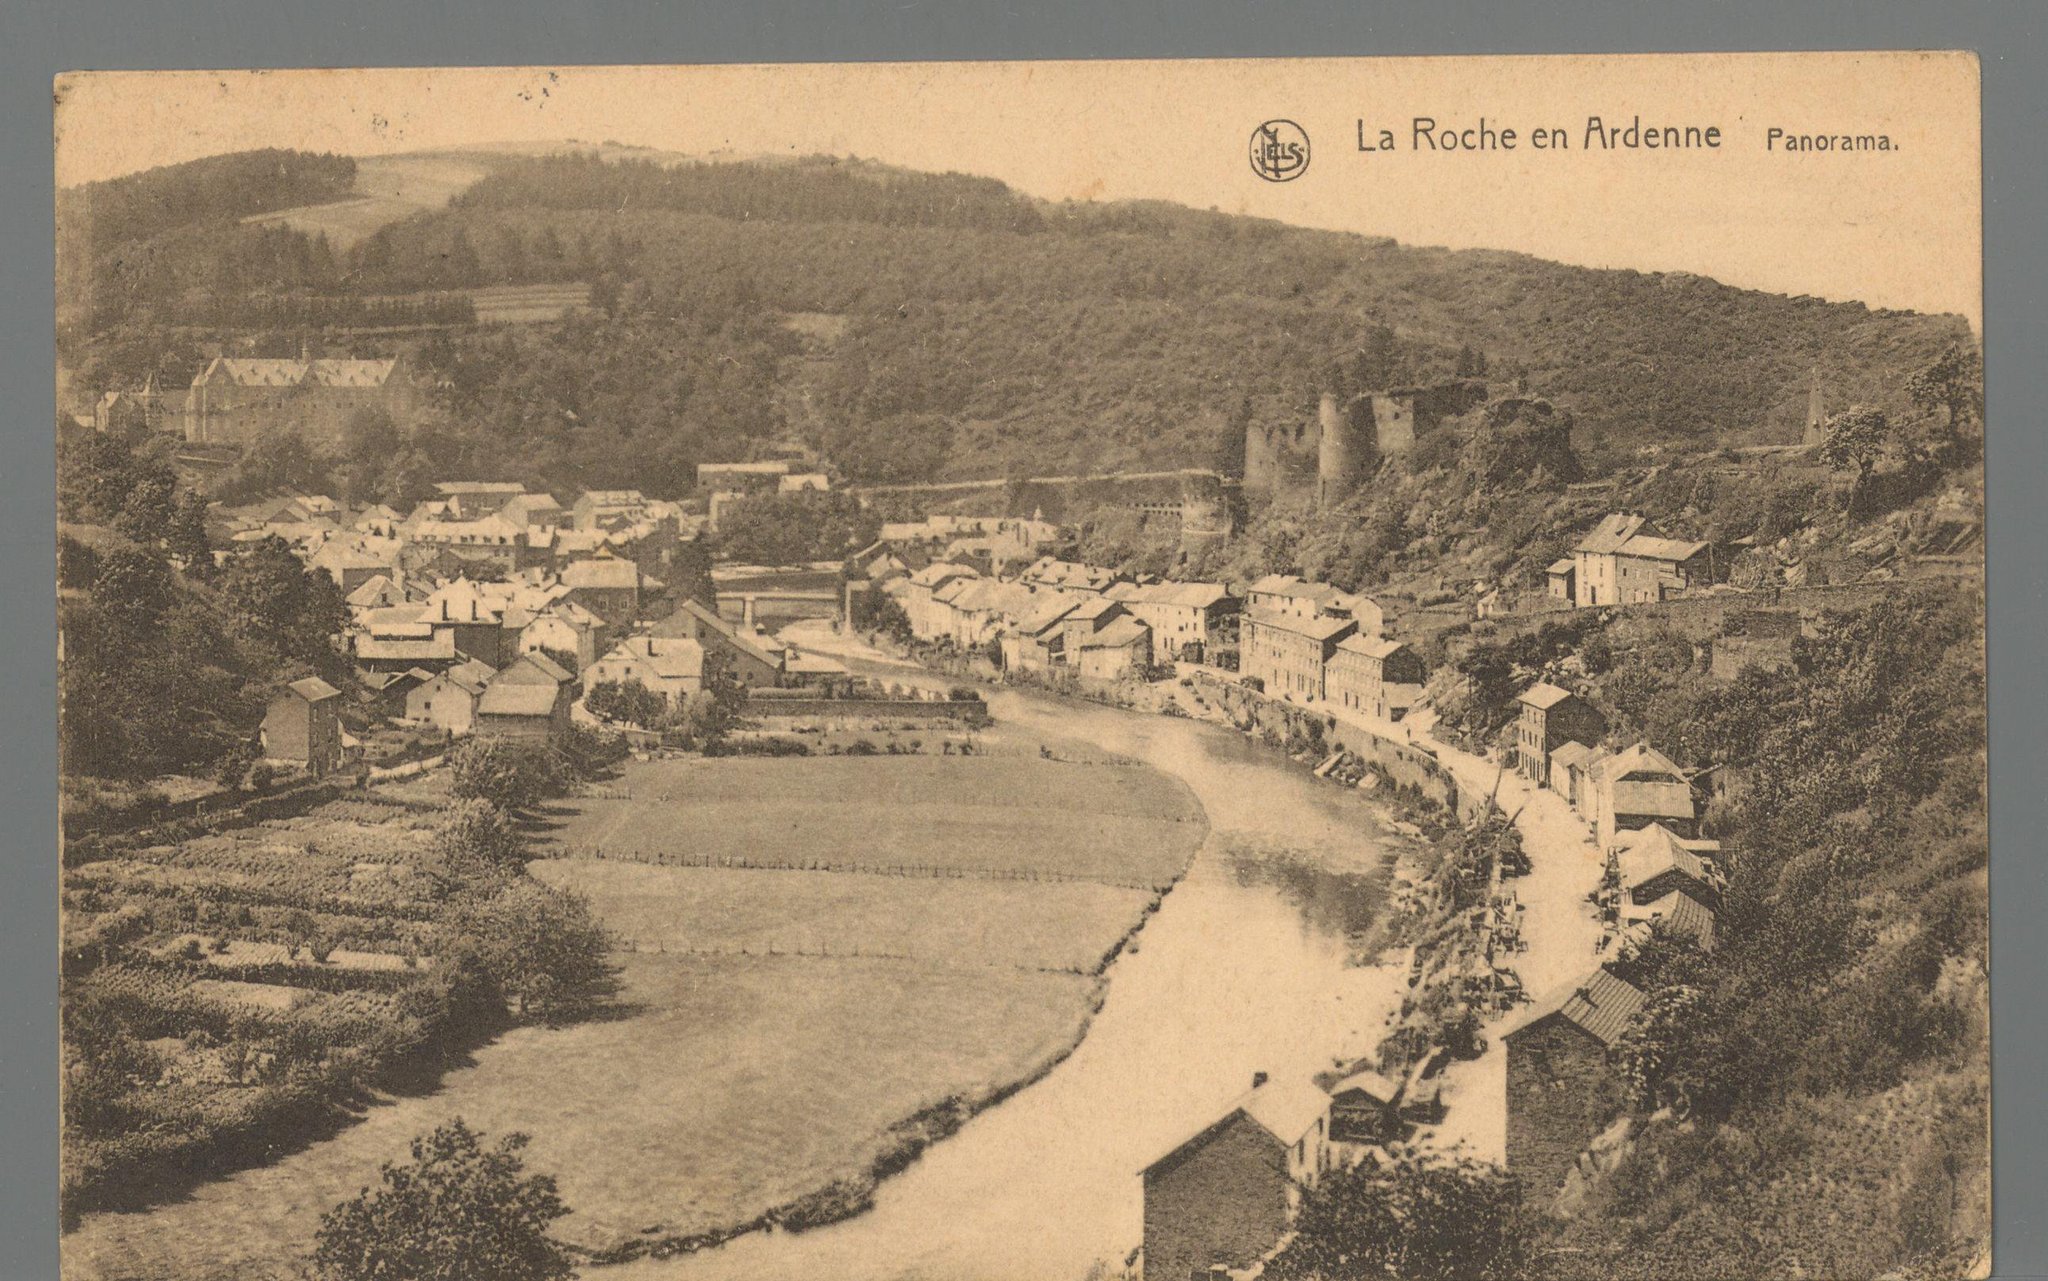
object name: photomechanical print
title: La Roche en Andenne. Panorama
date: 1913-1927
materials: cardboard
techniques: photograph, writing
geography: la roche-en-ardenne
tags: castle, river, prospect of city, town panorama, silhouette of city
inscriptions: postage stamp